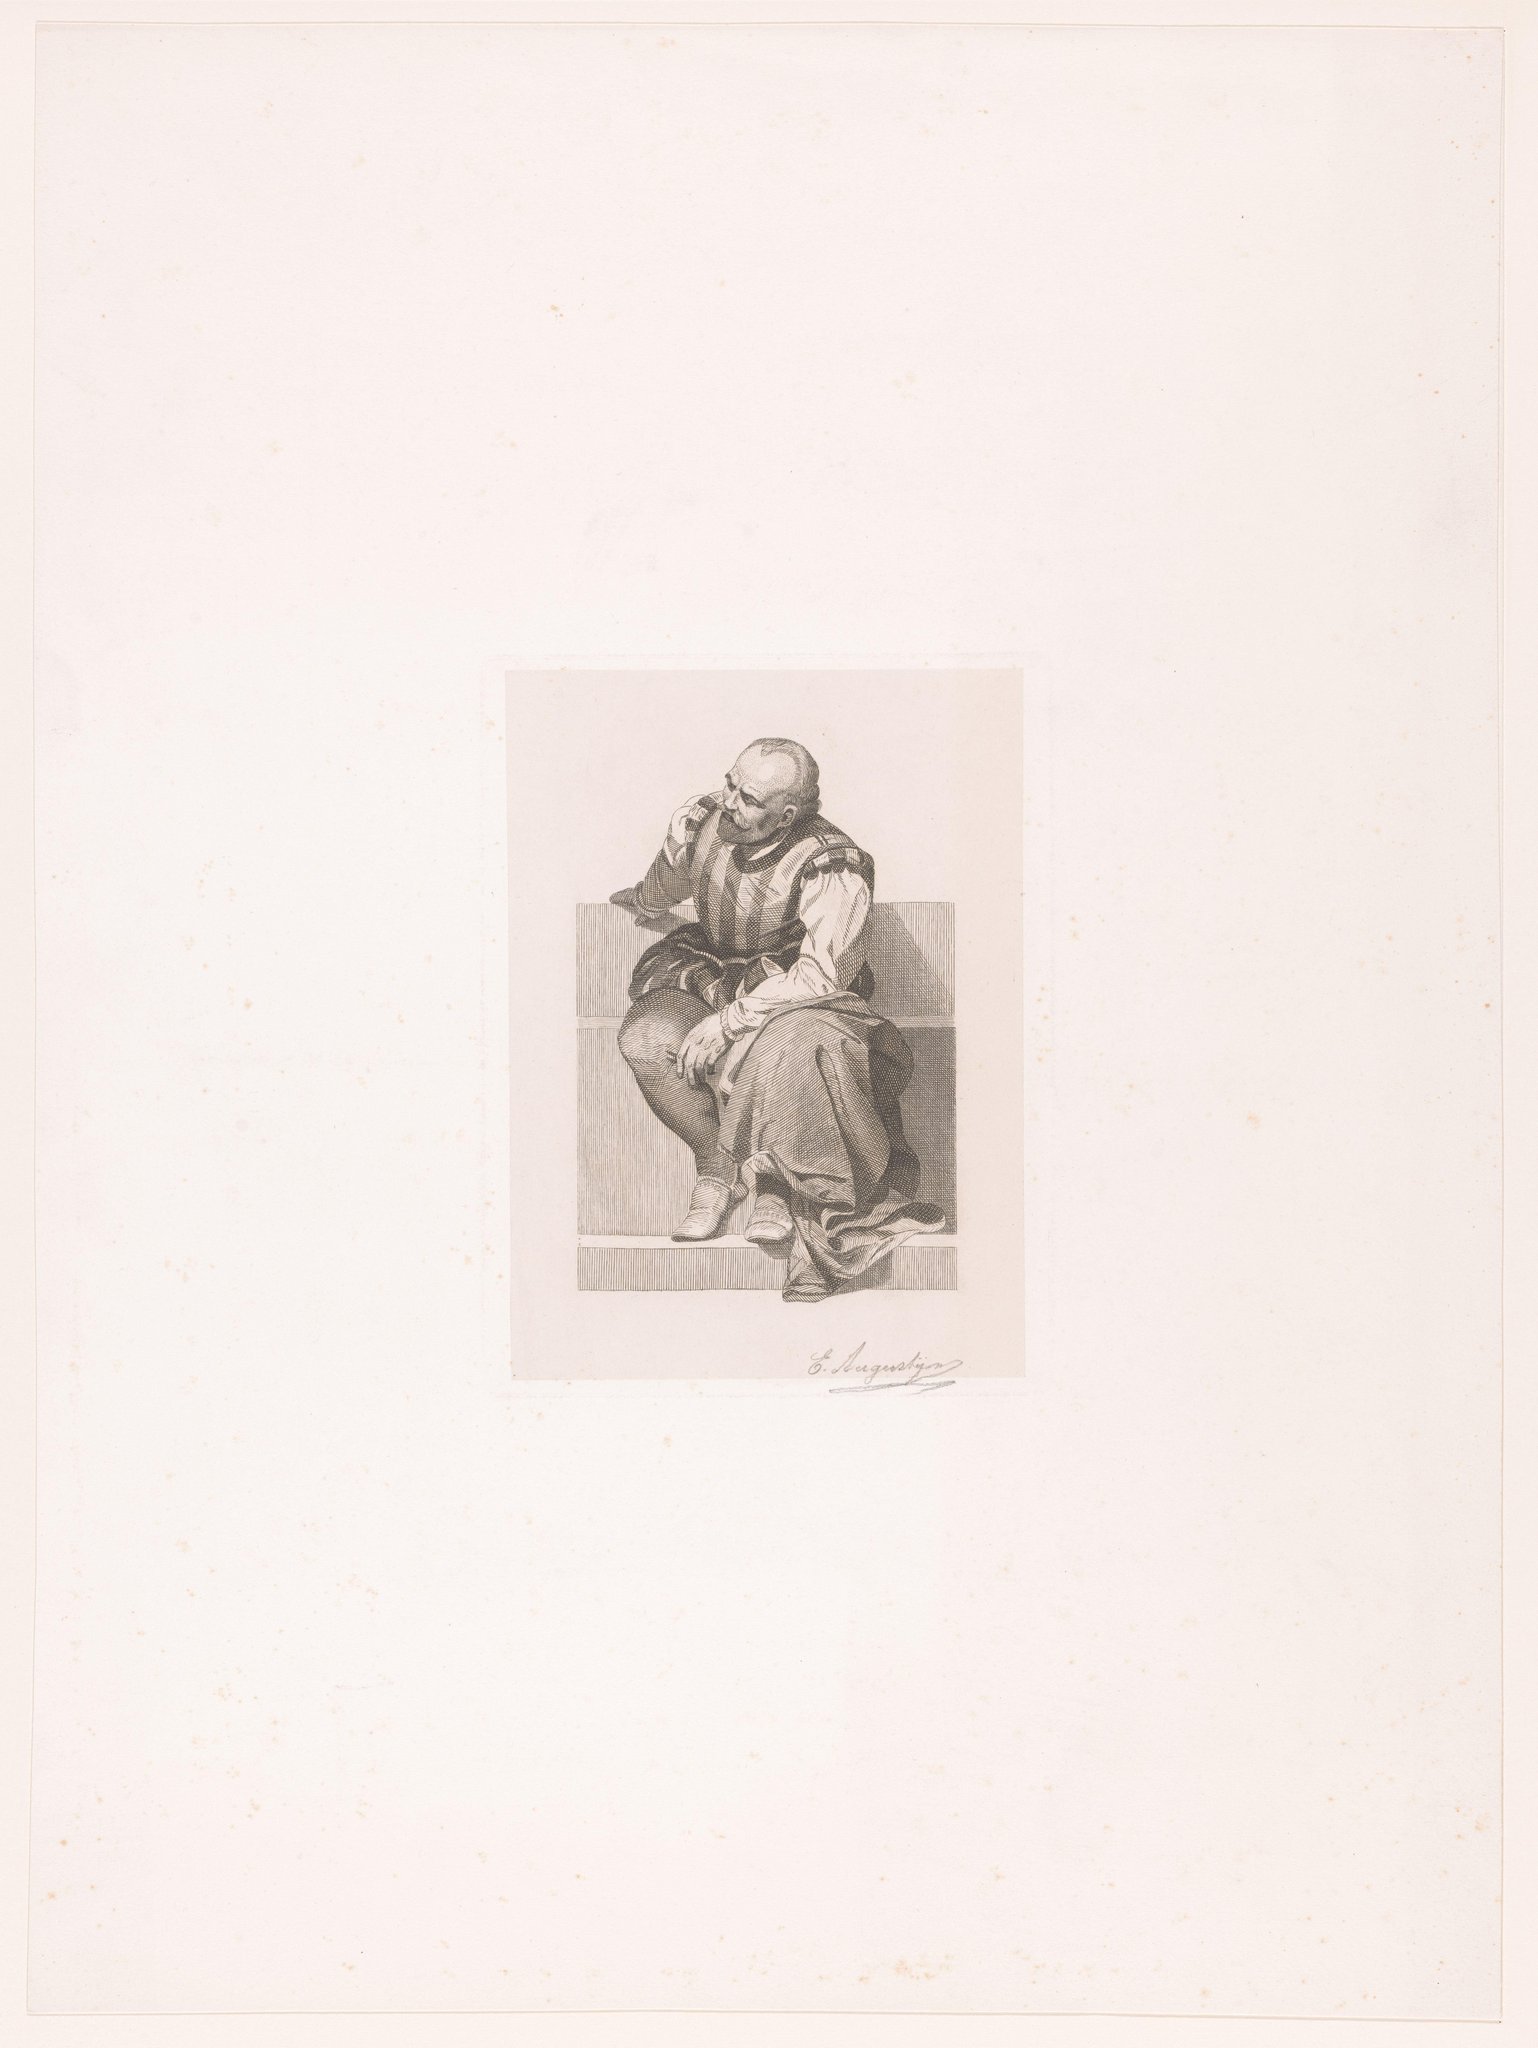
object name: print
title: Zittende man in middeleeuwse kleding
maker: eduard augustyns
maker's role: print maker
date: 1850-1909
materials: paper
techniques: engraving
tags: sitting on an elevation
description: Sterfdatum kunstenaar onbekend. Derhalve is voor bepaling van de rechten van dit object de verwervingsdatum aangehouden.